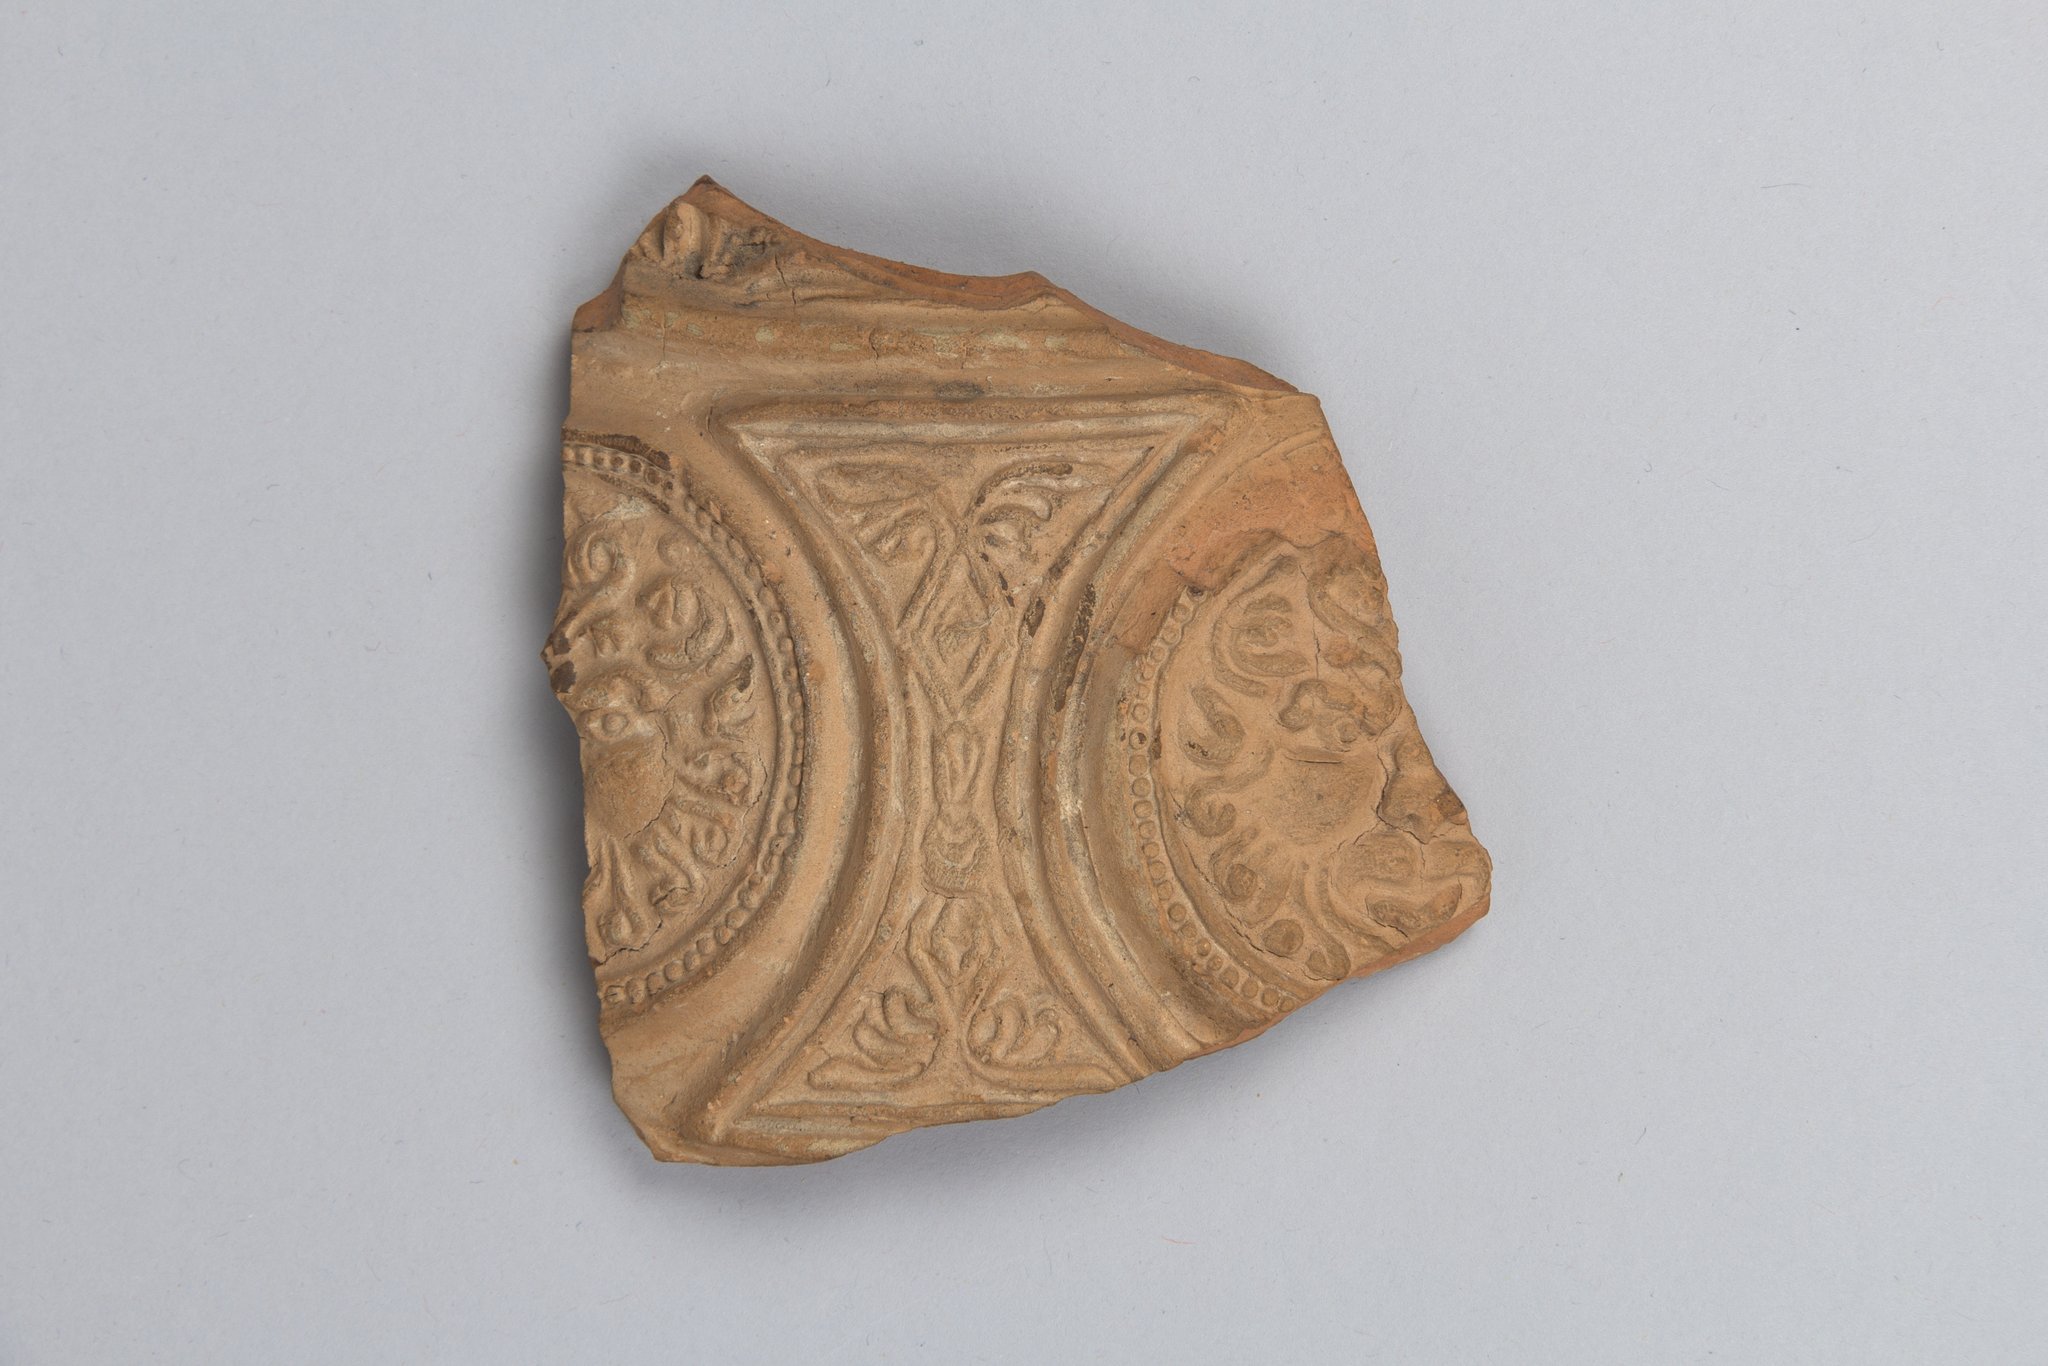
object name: shard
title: Shard with Ornament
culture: central asian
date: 1101-1133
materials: terracotta